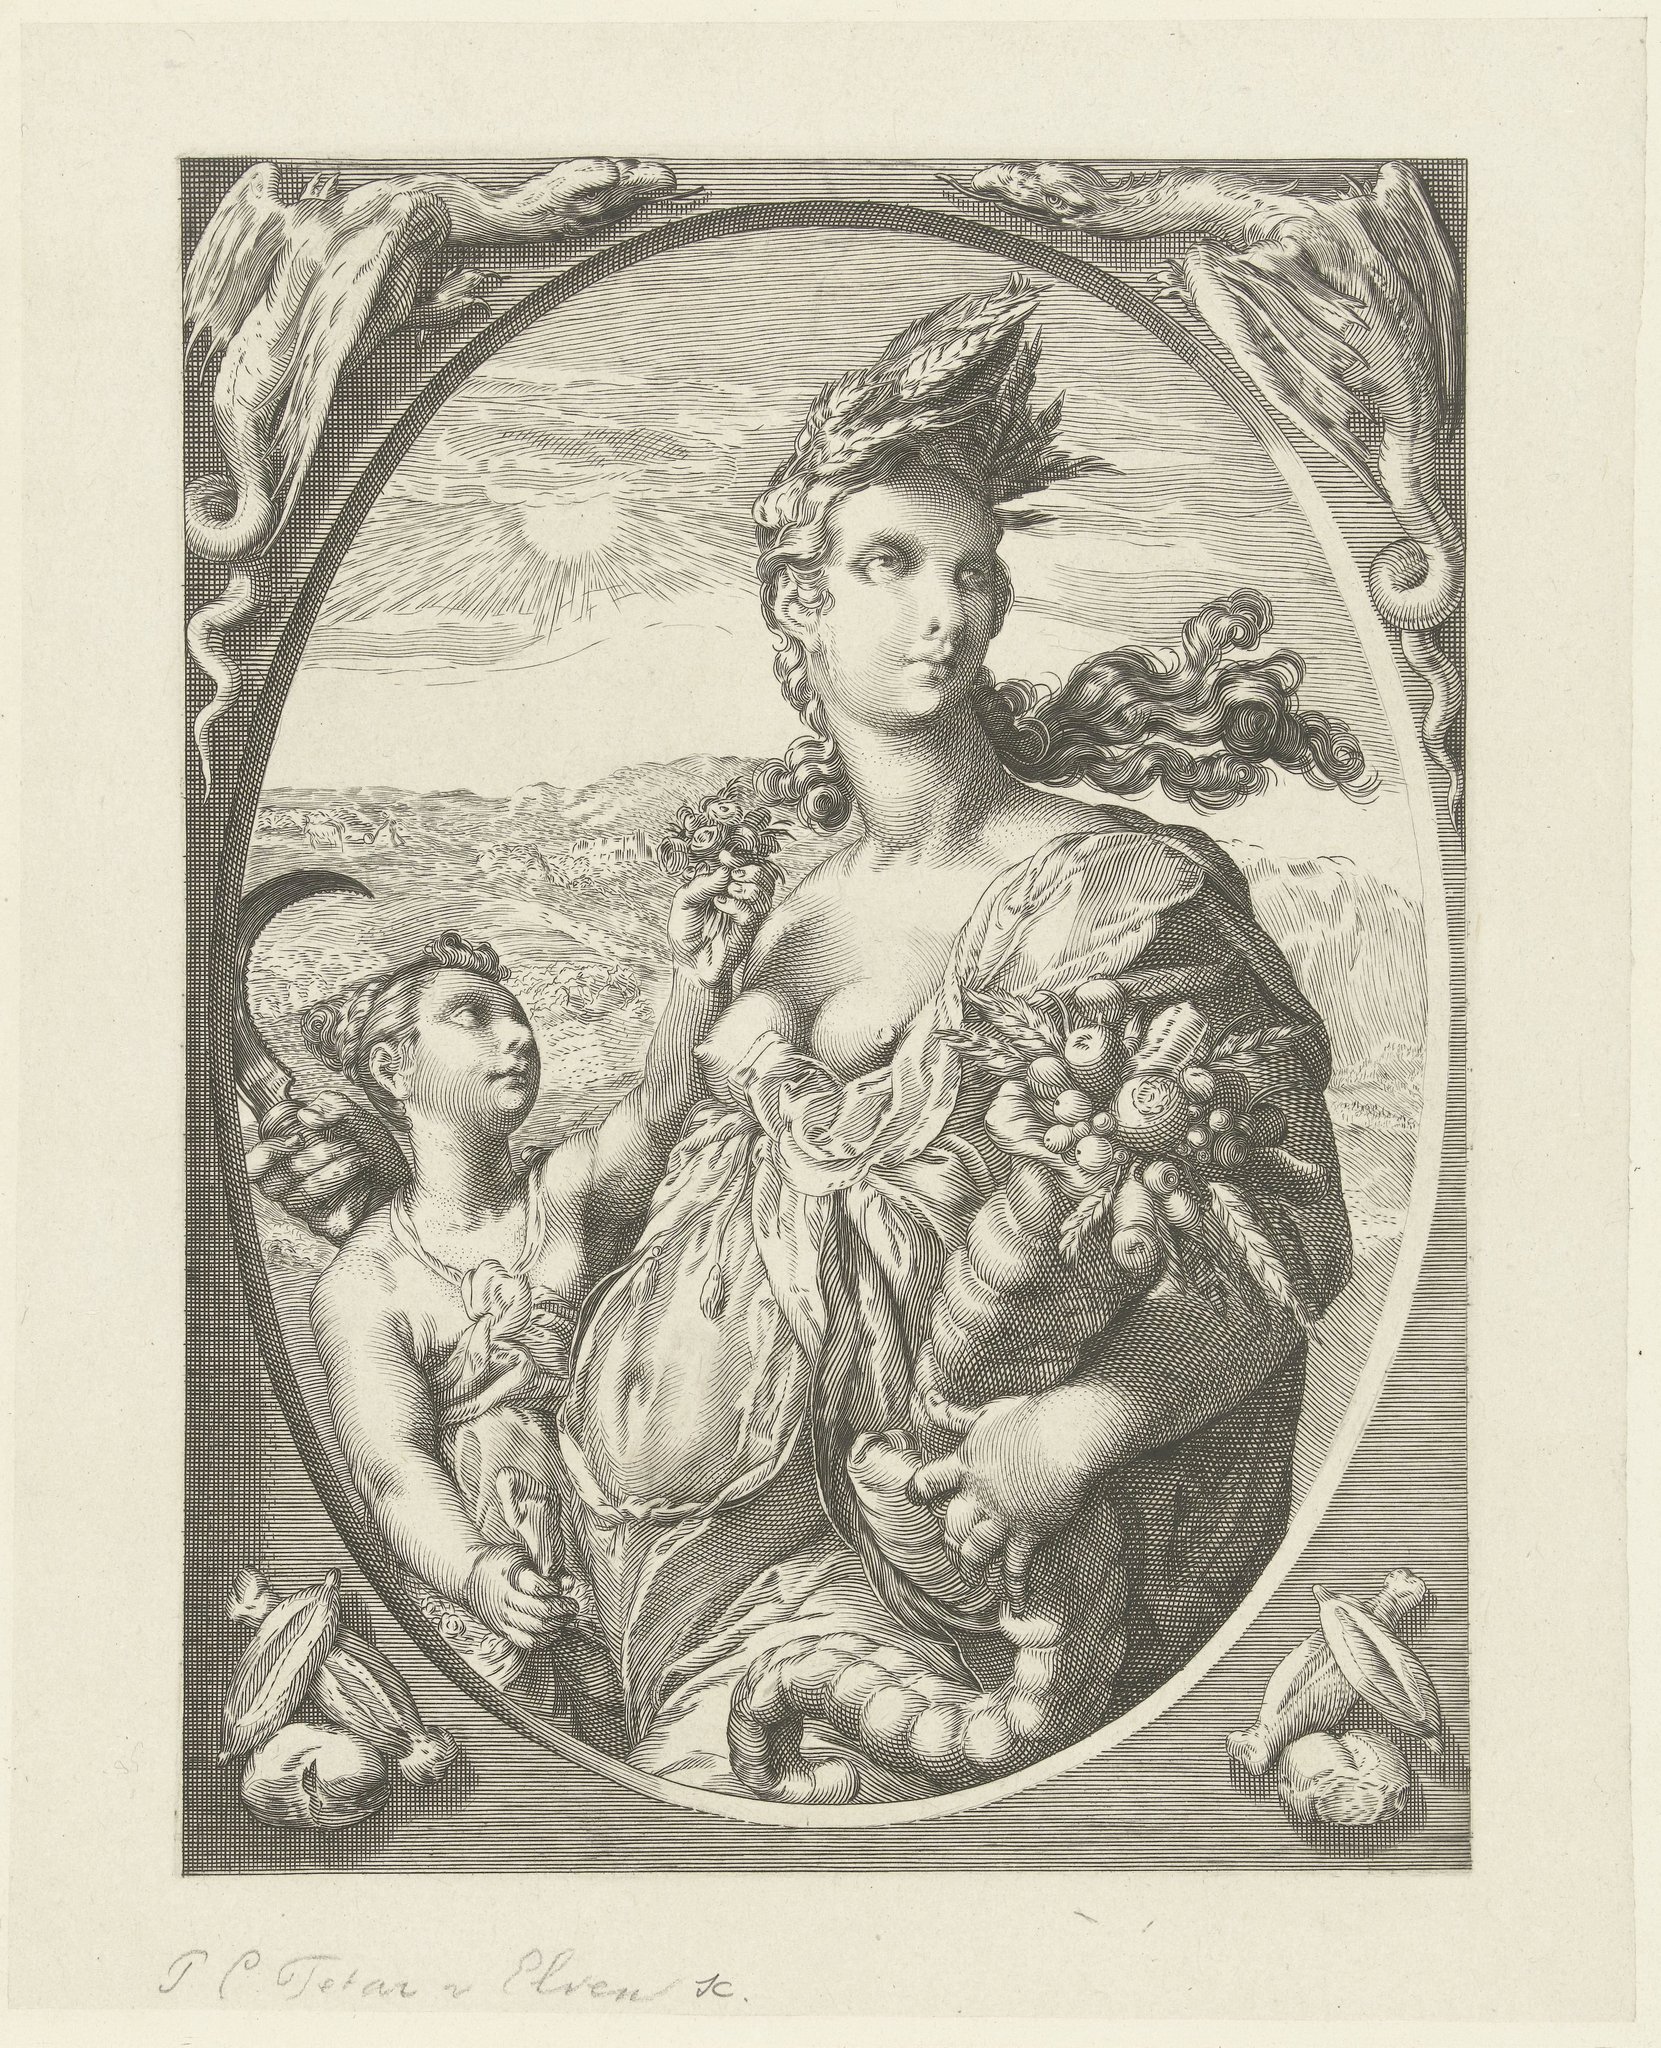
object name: print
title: Ceres en Proserpina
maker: paul tetar van elven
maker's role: print maker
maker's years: 1823-1896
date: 1833-1880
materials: paper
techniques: engraving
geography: haarlem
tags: (story of) ceres (demeter)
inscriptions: collector's mark: Lugt 2228, inscription: ‘te herkennen van het origineel hieraan dat op het origineel tusschen de horizontale lijnen ... ...’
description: Ceres, de godin van de landbouw, als belichaming van de overvloed der aarde. Op haar hoofd draagt ze een kroon van korenaren, in haar arm heeft ze de hoorn des overvloeds en in haar hand een sikkel. Naast haar staat haar dochter Proserpina. In de hoeken van de omlijsting zijn twee draken en landbouwproducten weergegeven.